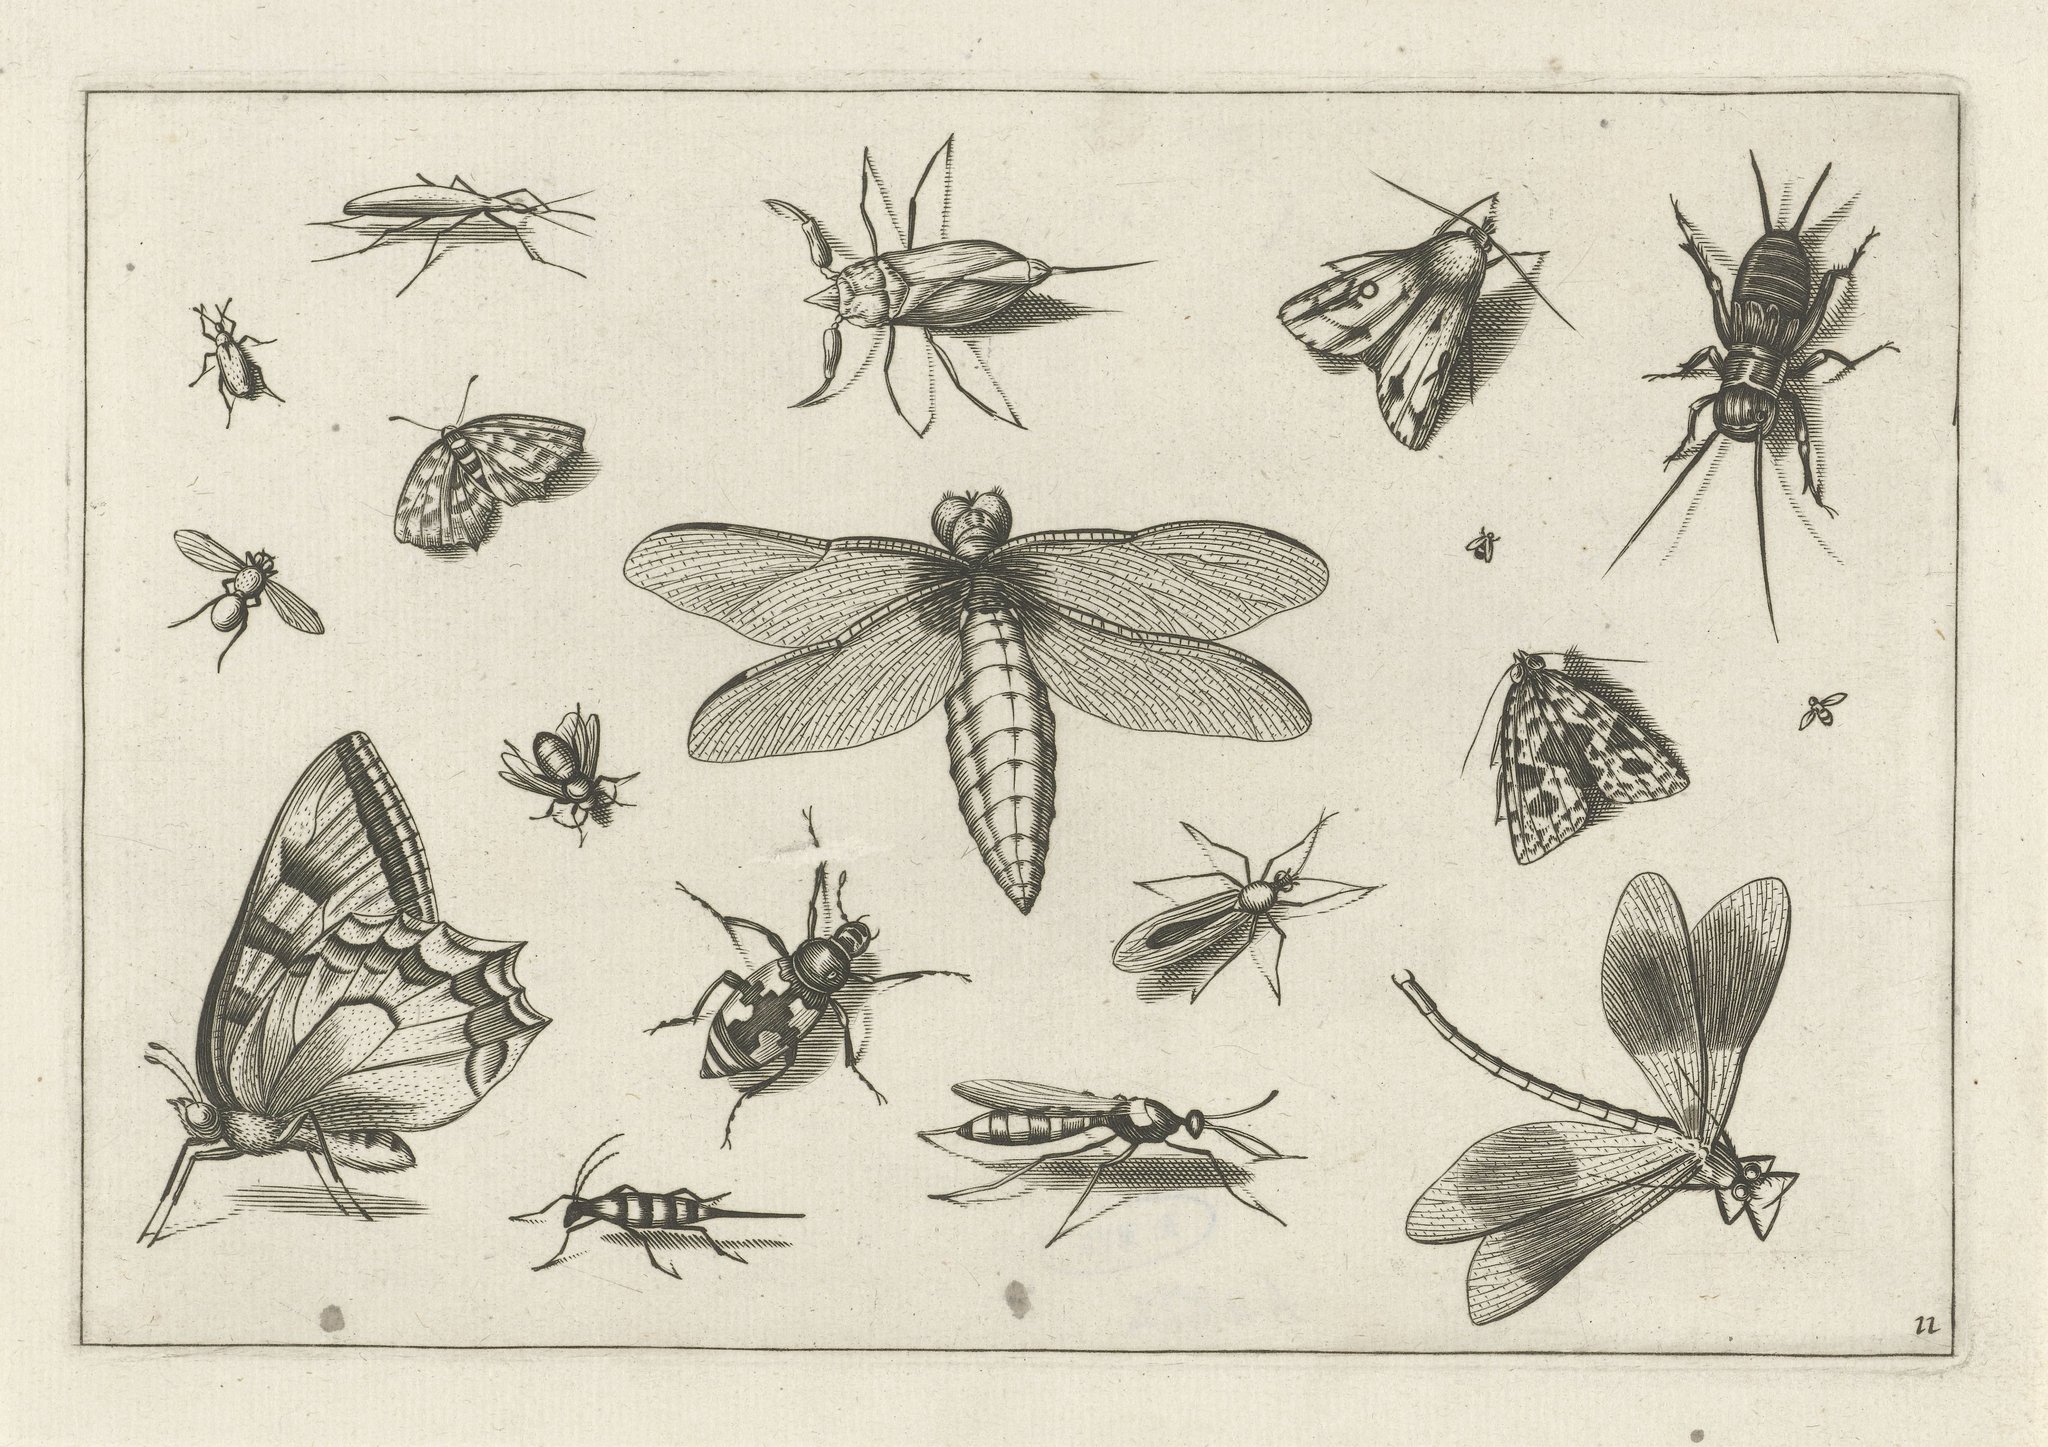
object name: print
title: Insecten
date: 1630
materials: paper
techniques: engraving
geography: low countries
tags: insects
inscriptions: collector's mark: Lugt 2228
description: Verschillende insecten met in het midden een libelle.